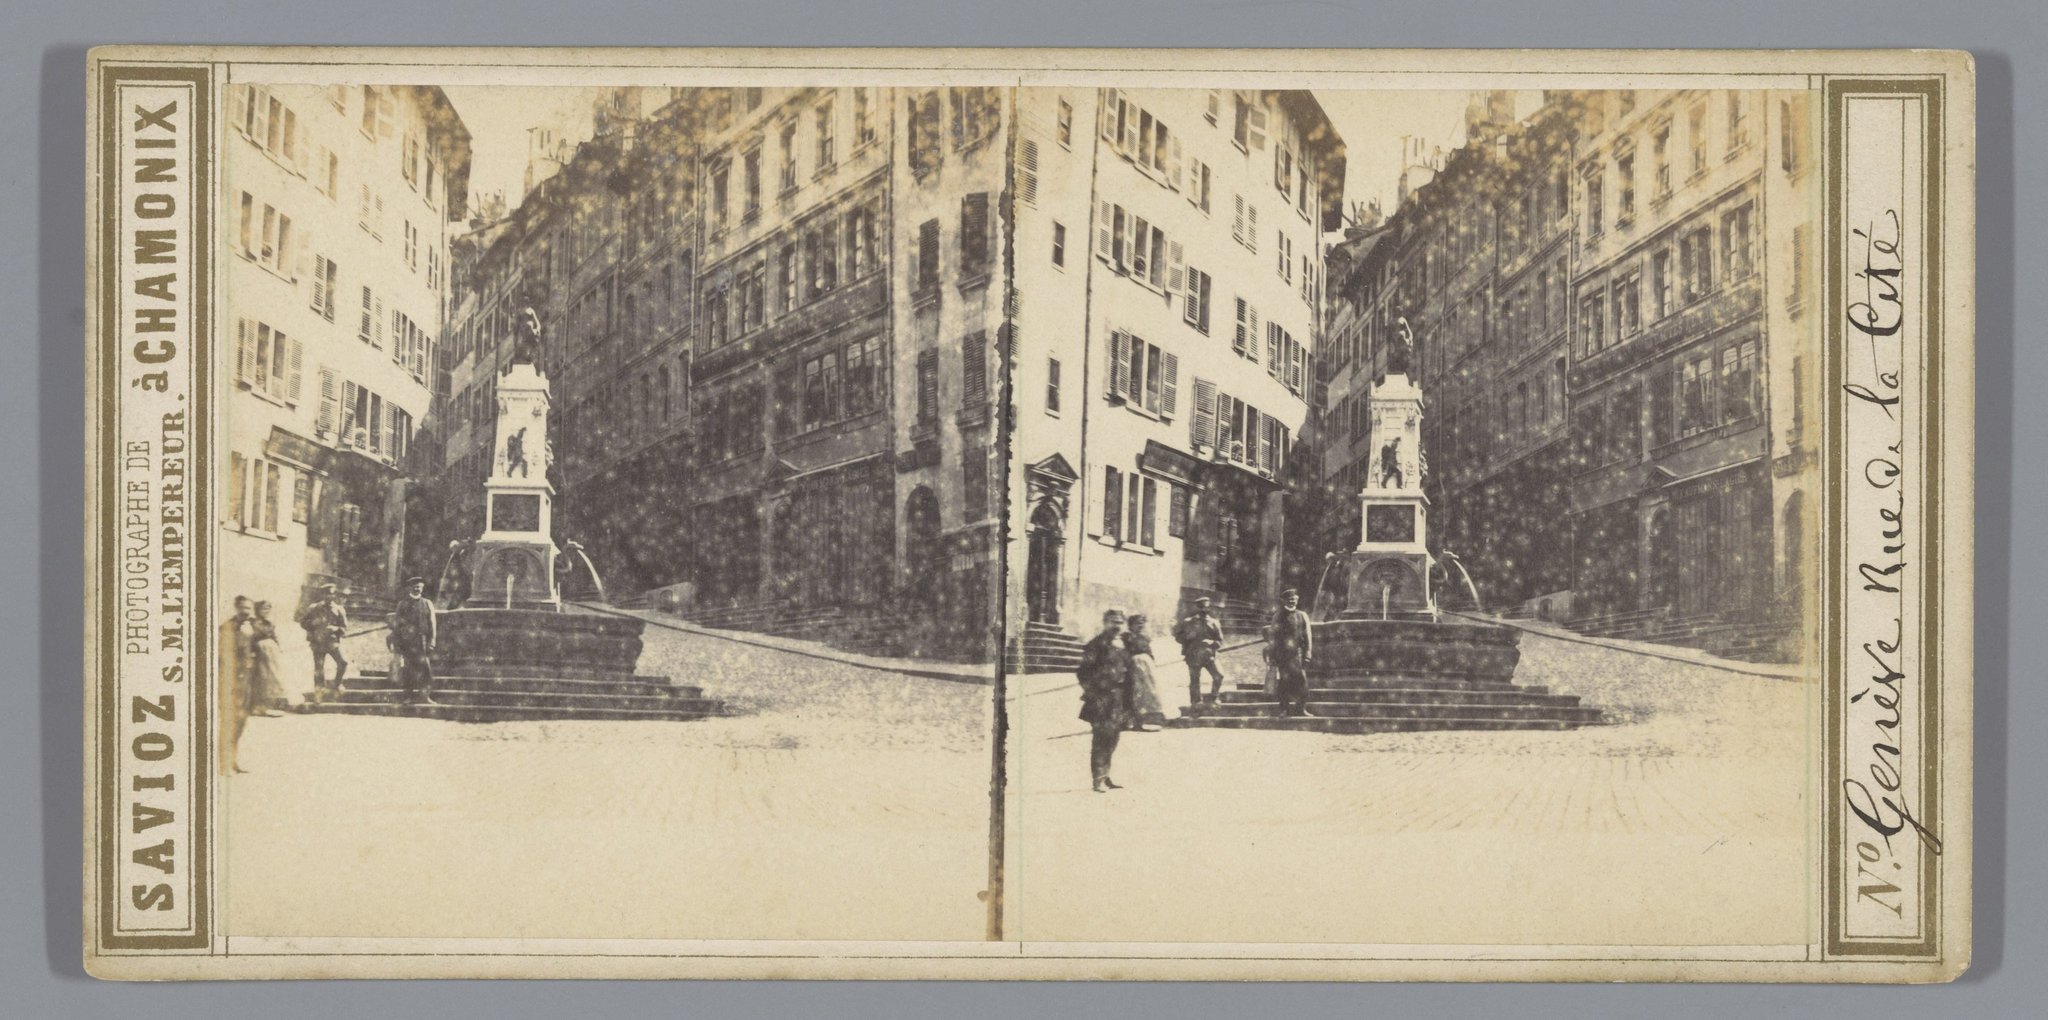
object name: stereograph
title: Gezicht op de Rue de la Cité te Genève, met op de voorgrond een fontein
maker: eugène savioz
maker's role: fotograaf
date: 1860-1880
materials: cardboard, photographic support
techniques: albumen print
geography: geneva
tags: ornamental fountain, street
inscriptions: name: ‘Savioz à Chamonix Photographe de S.M.L'Empereur.’, inscription: ‘Genève Rue de la Cité’